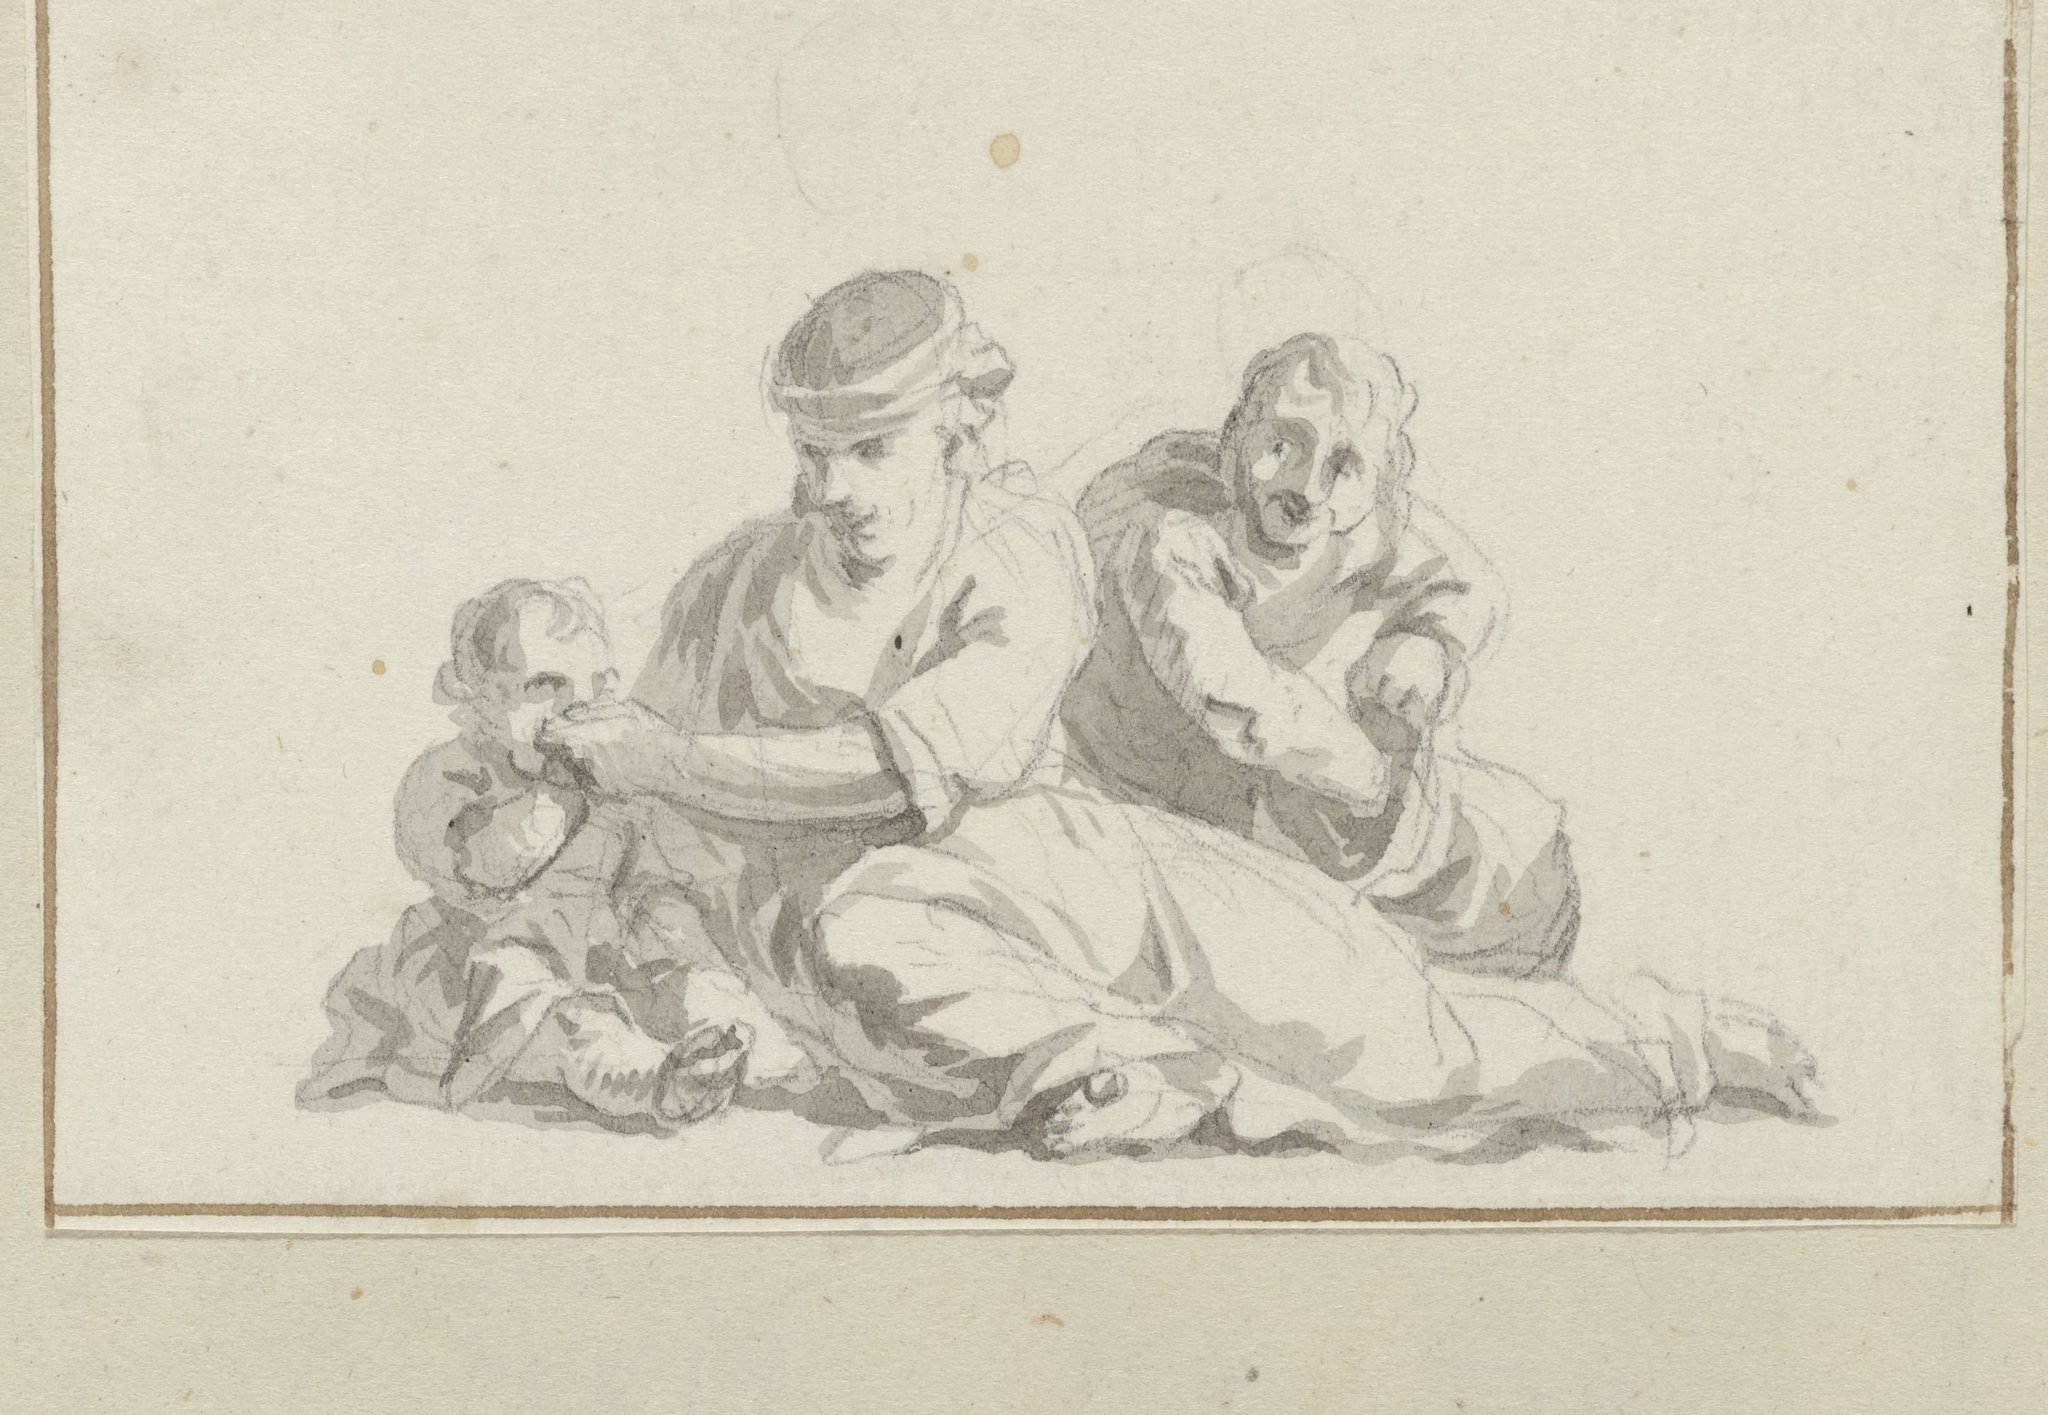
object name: drawing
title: Kind, man en vrouw, zittend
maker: Anonymous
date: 1700-1799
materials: ink, paper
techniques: brush, pen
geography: netherlands